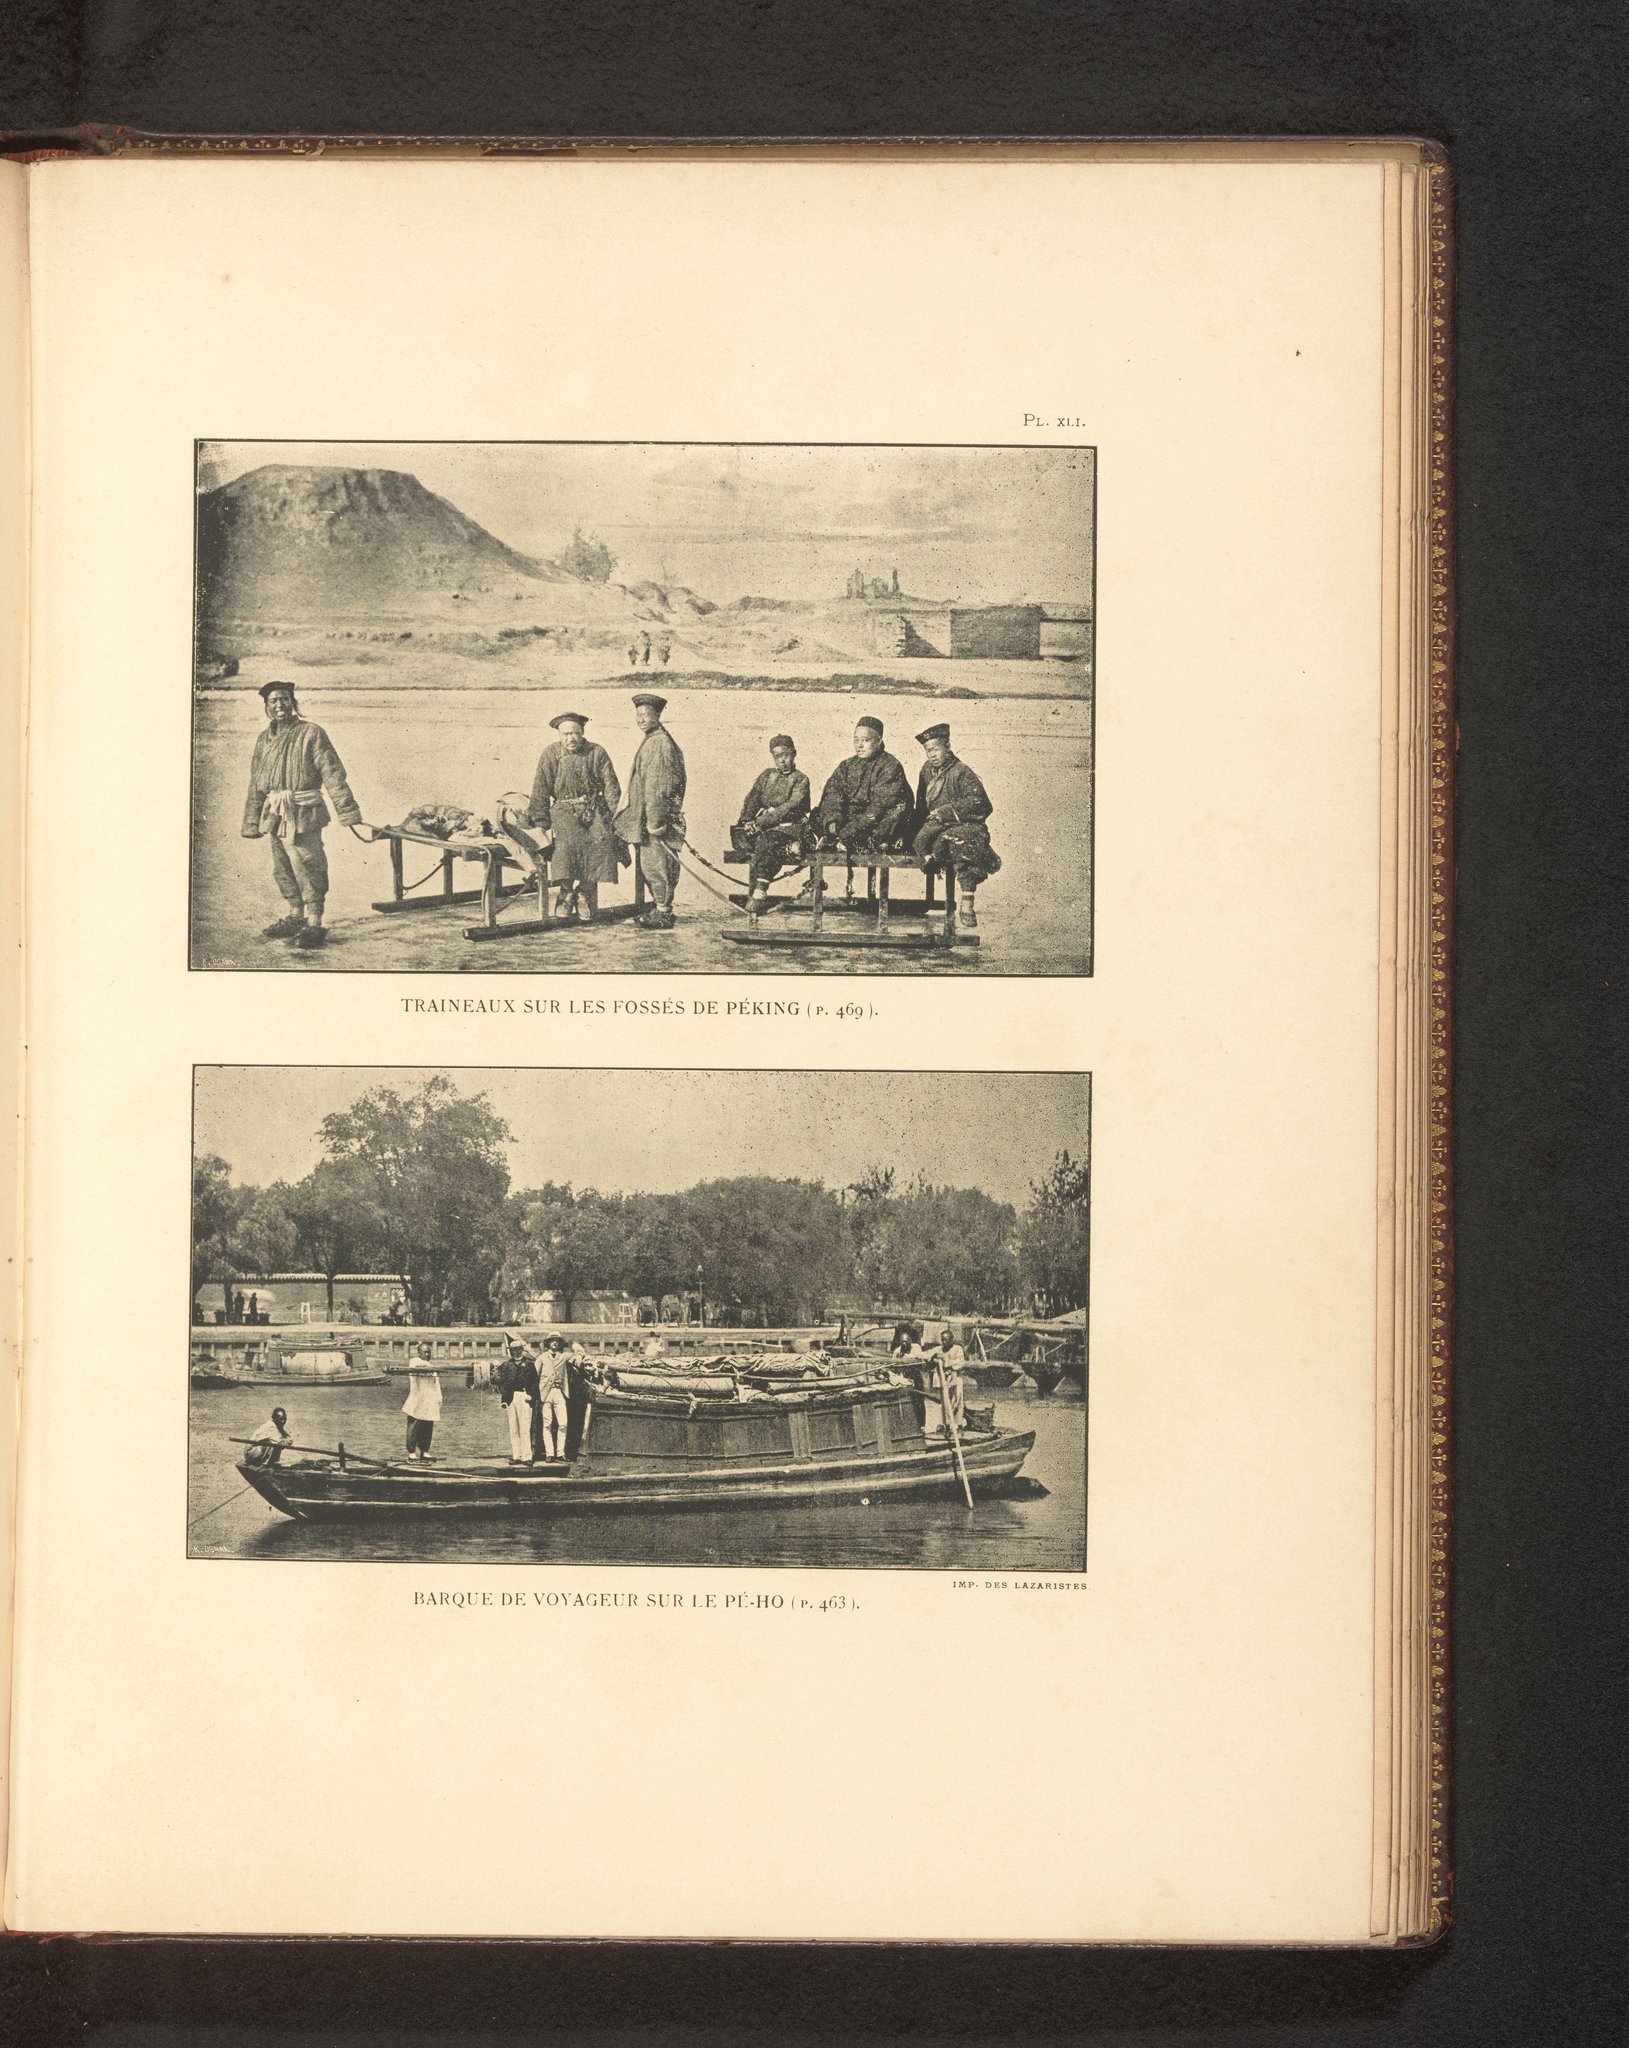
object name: photomechanical print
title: Groep onbekende mannen met sledes op het ijs en Gezicht op onbekende mannen op een boot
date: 1892-1897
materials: paper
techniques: autotype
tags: sleigh, sledge (non-sport), traffic on the water, china